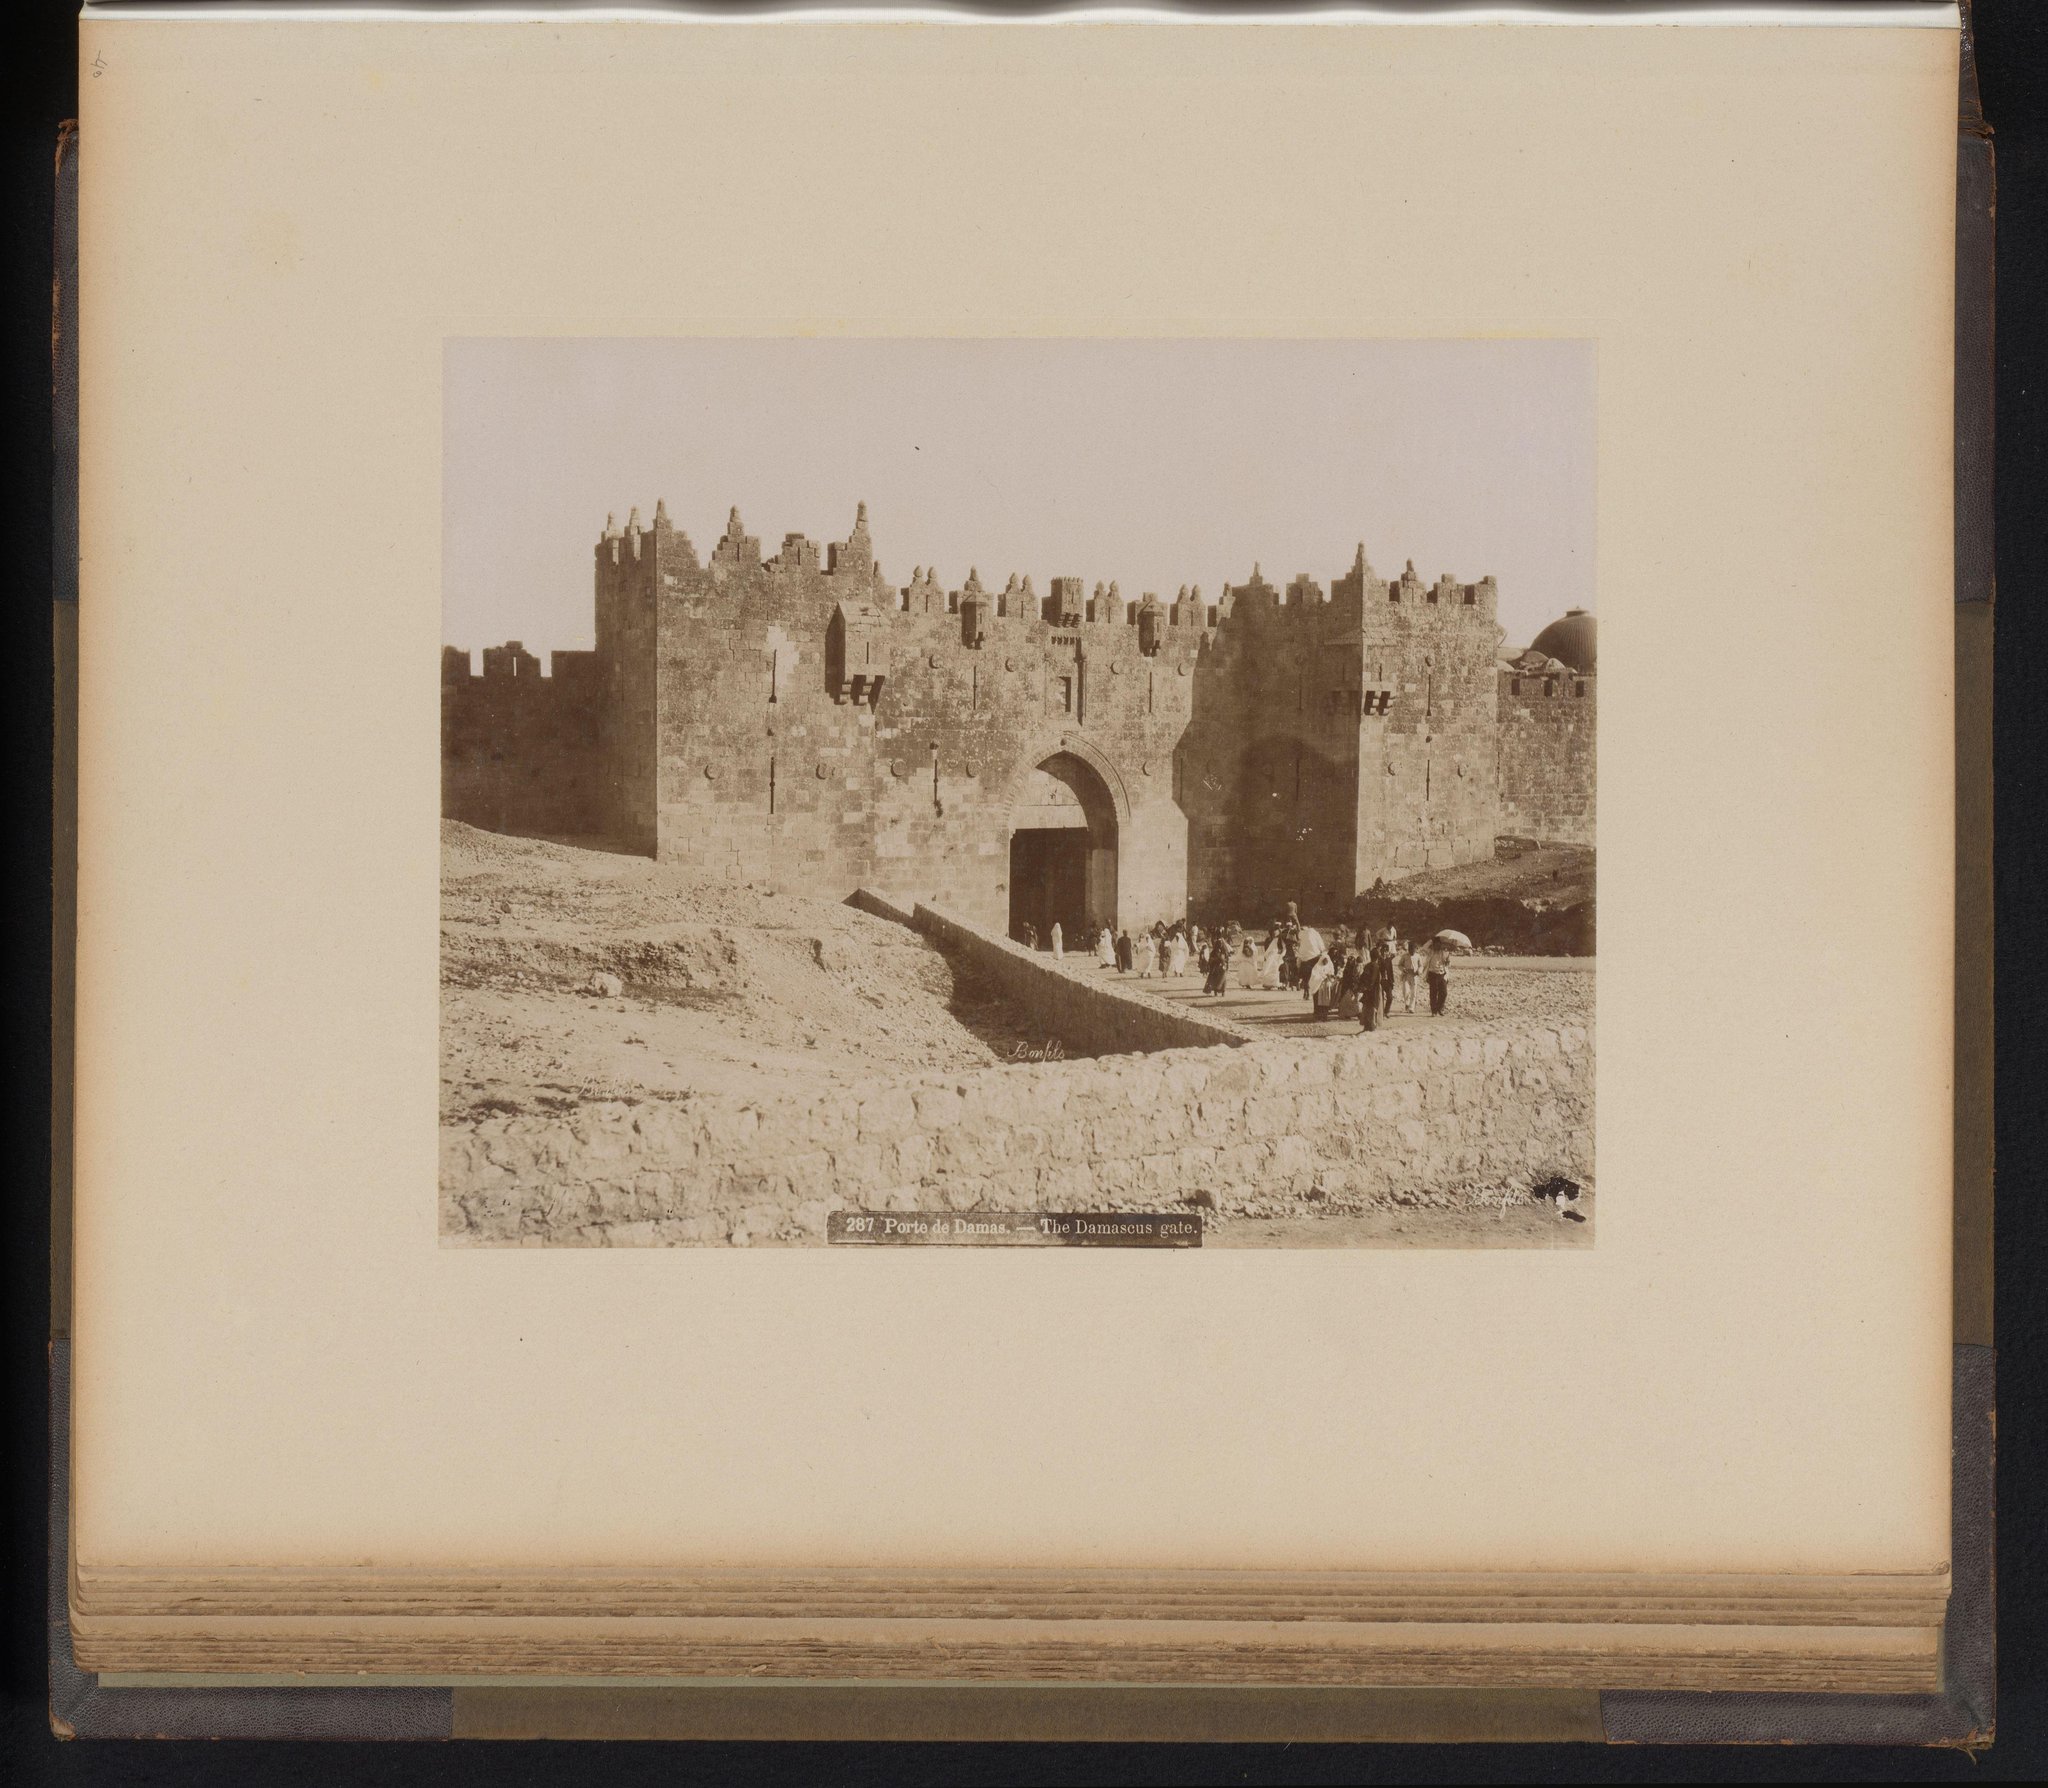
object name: photograph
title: Damascuspoort in Jeruzalem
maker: félix bonfils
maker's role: fotograaf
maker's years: 1831-1885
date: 1867-1885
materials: paper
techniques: albumen print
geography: jerusalem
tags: gate ~ fortified city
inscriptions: number: ‘287’